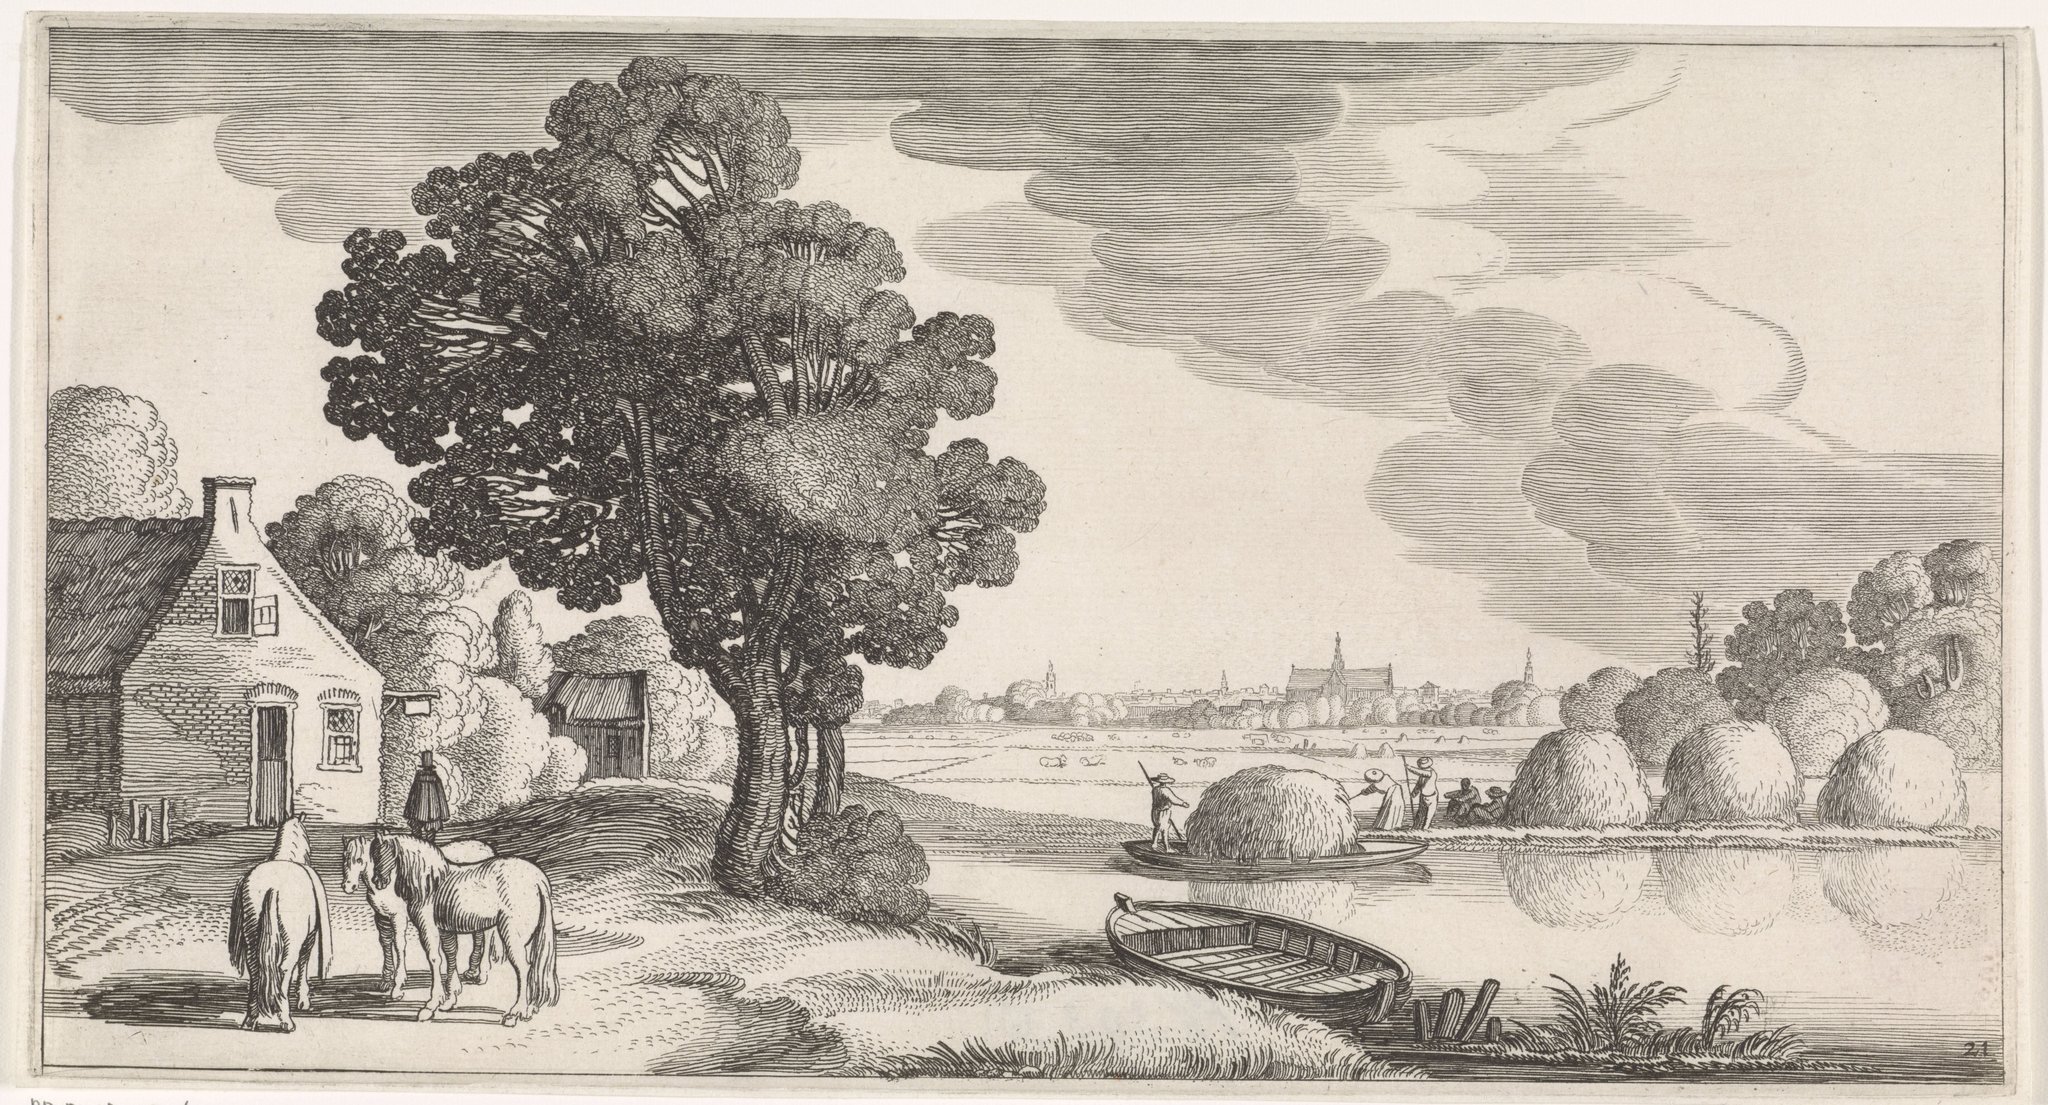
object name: print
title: Transport van hooi op een rivier met Haarlem in de verte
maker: jan van de velde (ii)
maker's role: draughtsman, painter, print maker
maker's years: 1593-1641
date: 1639-1641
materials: paper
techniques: etching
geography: northern netherlands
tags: agricultural products and by-products: hay, river, transporting ~ harvest, horse, hay-stack, haarlem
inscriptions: collector's mark: Lugt 240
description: Transport van hooi op een rivier. Op het water een hooischuit en aan de oever figuren bij drie hooibergen. Links een huis en een figuur en drie paarden op een pad. Aan de horizon Haarlem met onder andere de Sint-Bavokerk. Eenentwintigste prent van een serie met 36 prenten van landschappen, verdeeld over zes delen.